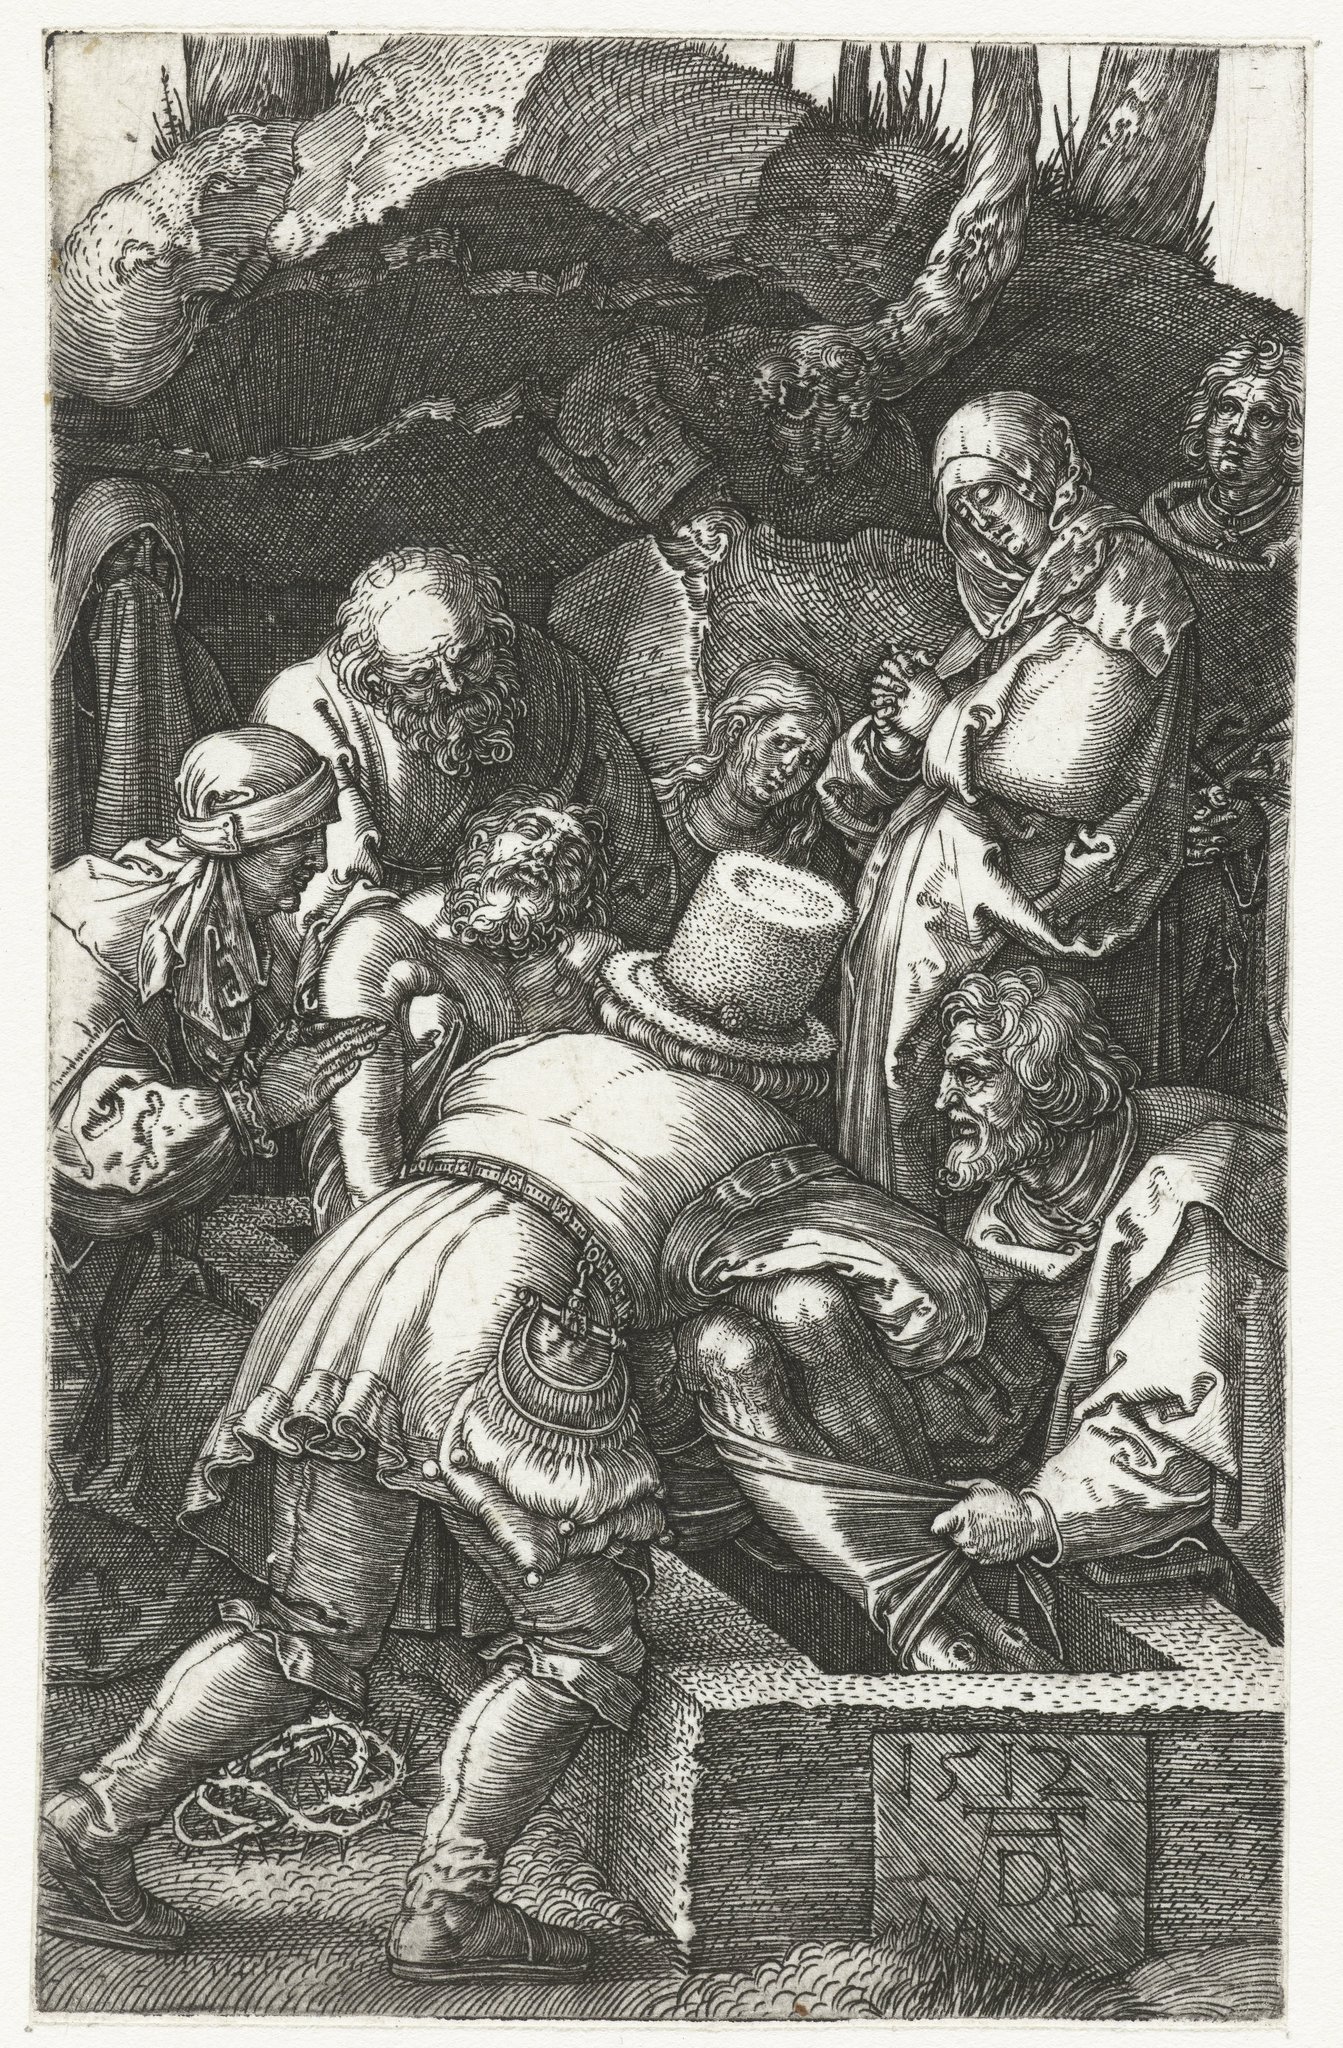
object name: print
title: De graflegging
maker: albrecht dürer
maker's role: draughtsman, painter, print maker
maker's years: 1471-1528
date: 1512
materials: paper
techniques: engraving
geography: nuremberg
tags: christ's entombment (possibly by angels)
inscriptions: collector's mark: Lugt 2228a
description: Christus wordt door drie mannen in een graf gelegd. Drie vrouwen staan of knielen bij deze mannen. Rechts op de achtergrond staat Johannes de evangelist. Deze prent is onderdeel van een serie van 16 prenten met scènes uit het Lijdensverhaal.